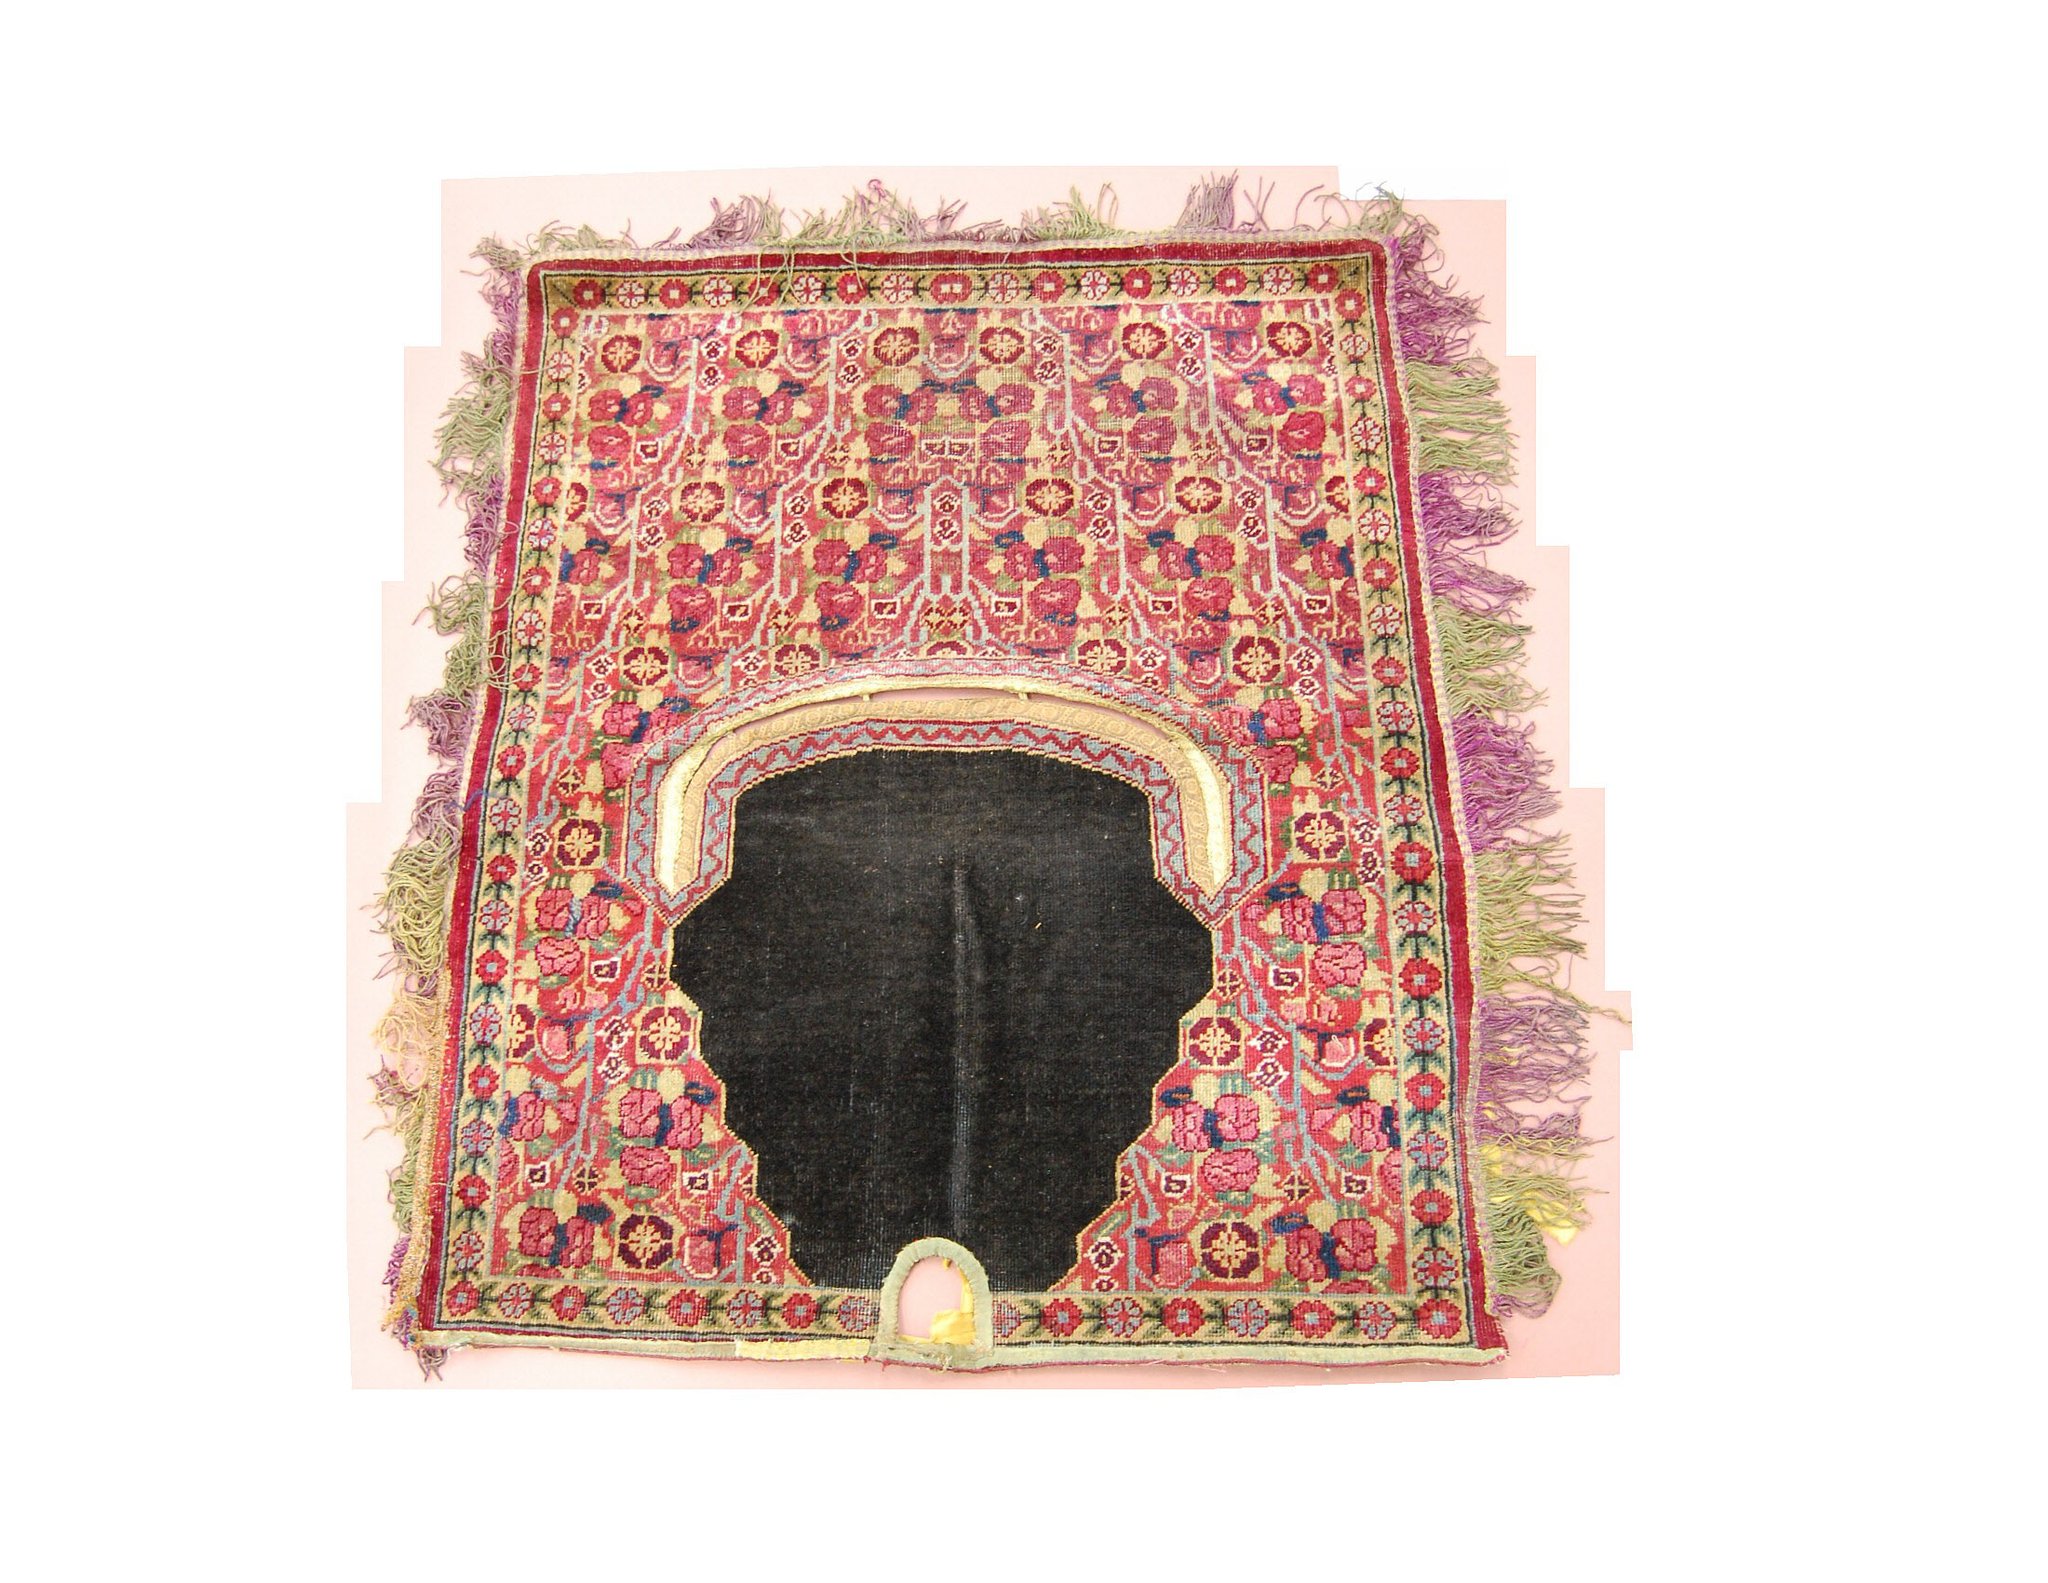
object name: saddle trapping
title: Saddle Trappings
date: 1501-1600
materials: metal thread, silk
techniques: embroidery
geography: india